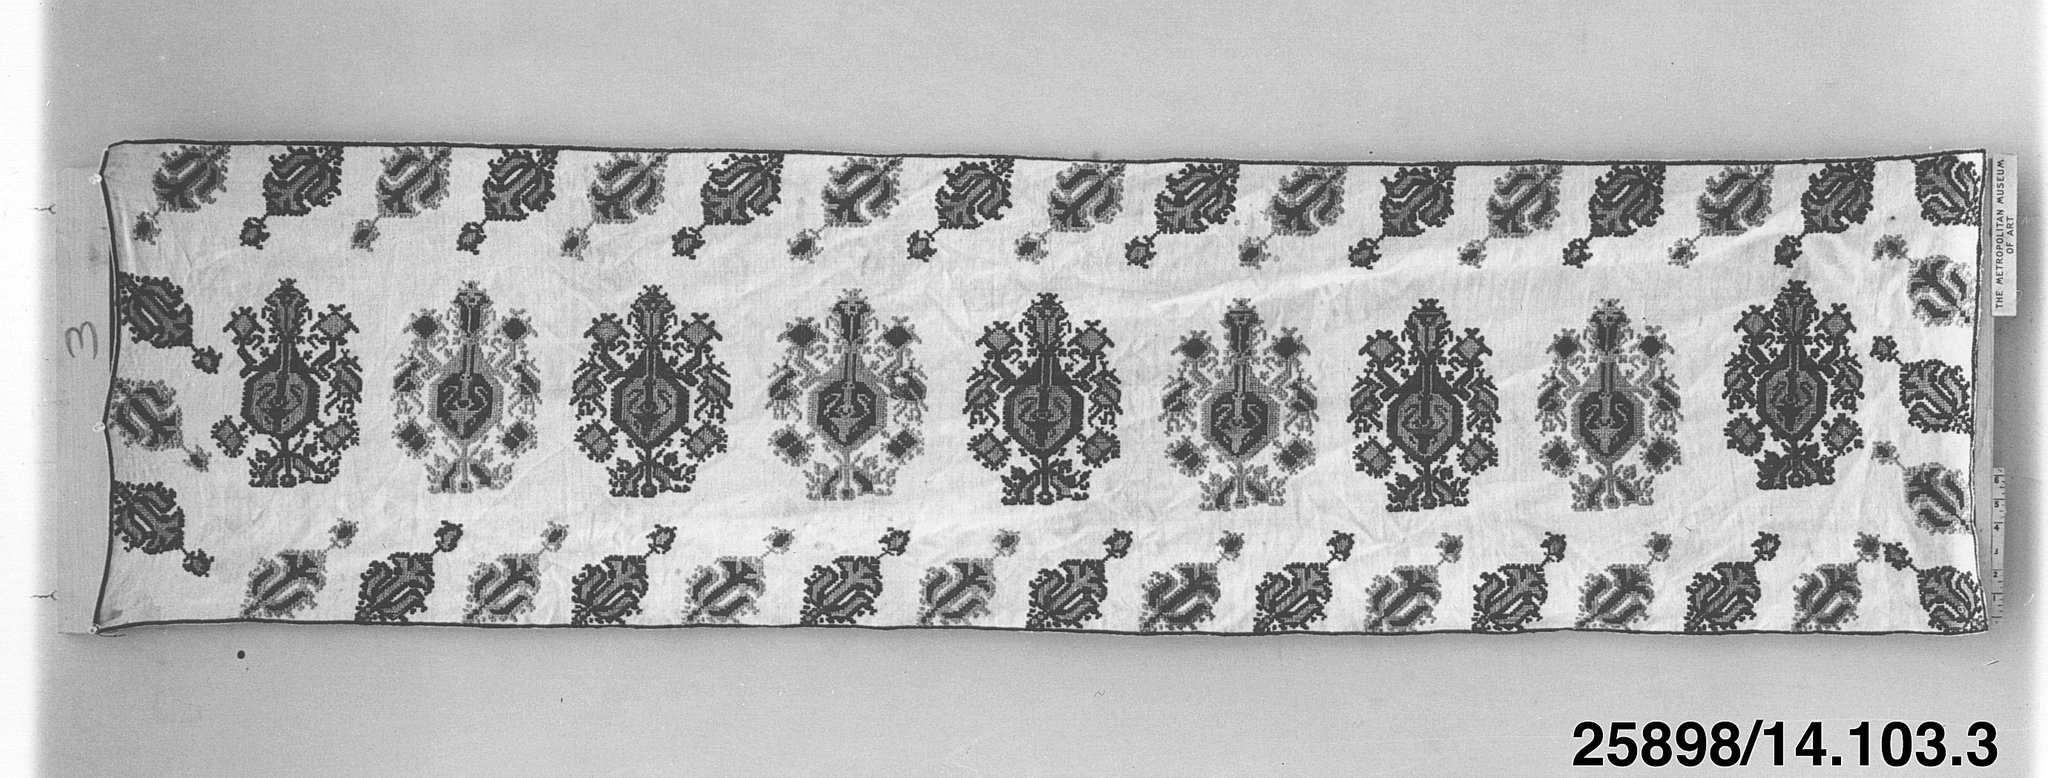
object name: bed valance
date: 1701-1800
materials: linen, silk